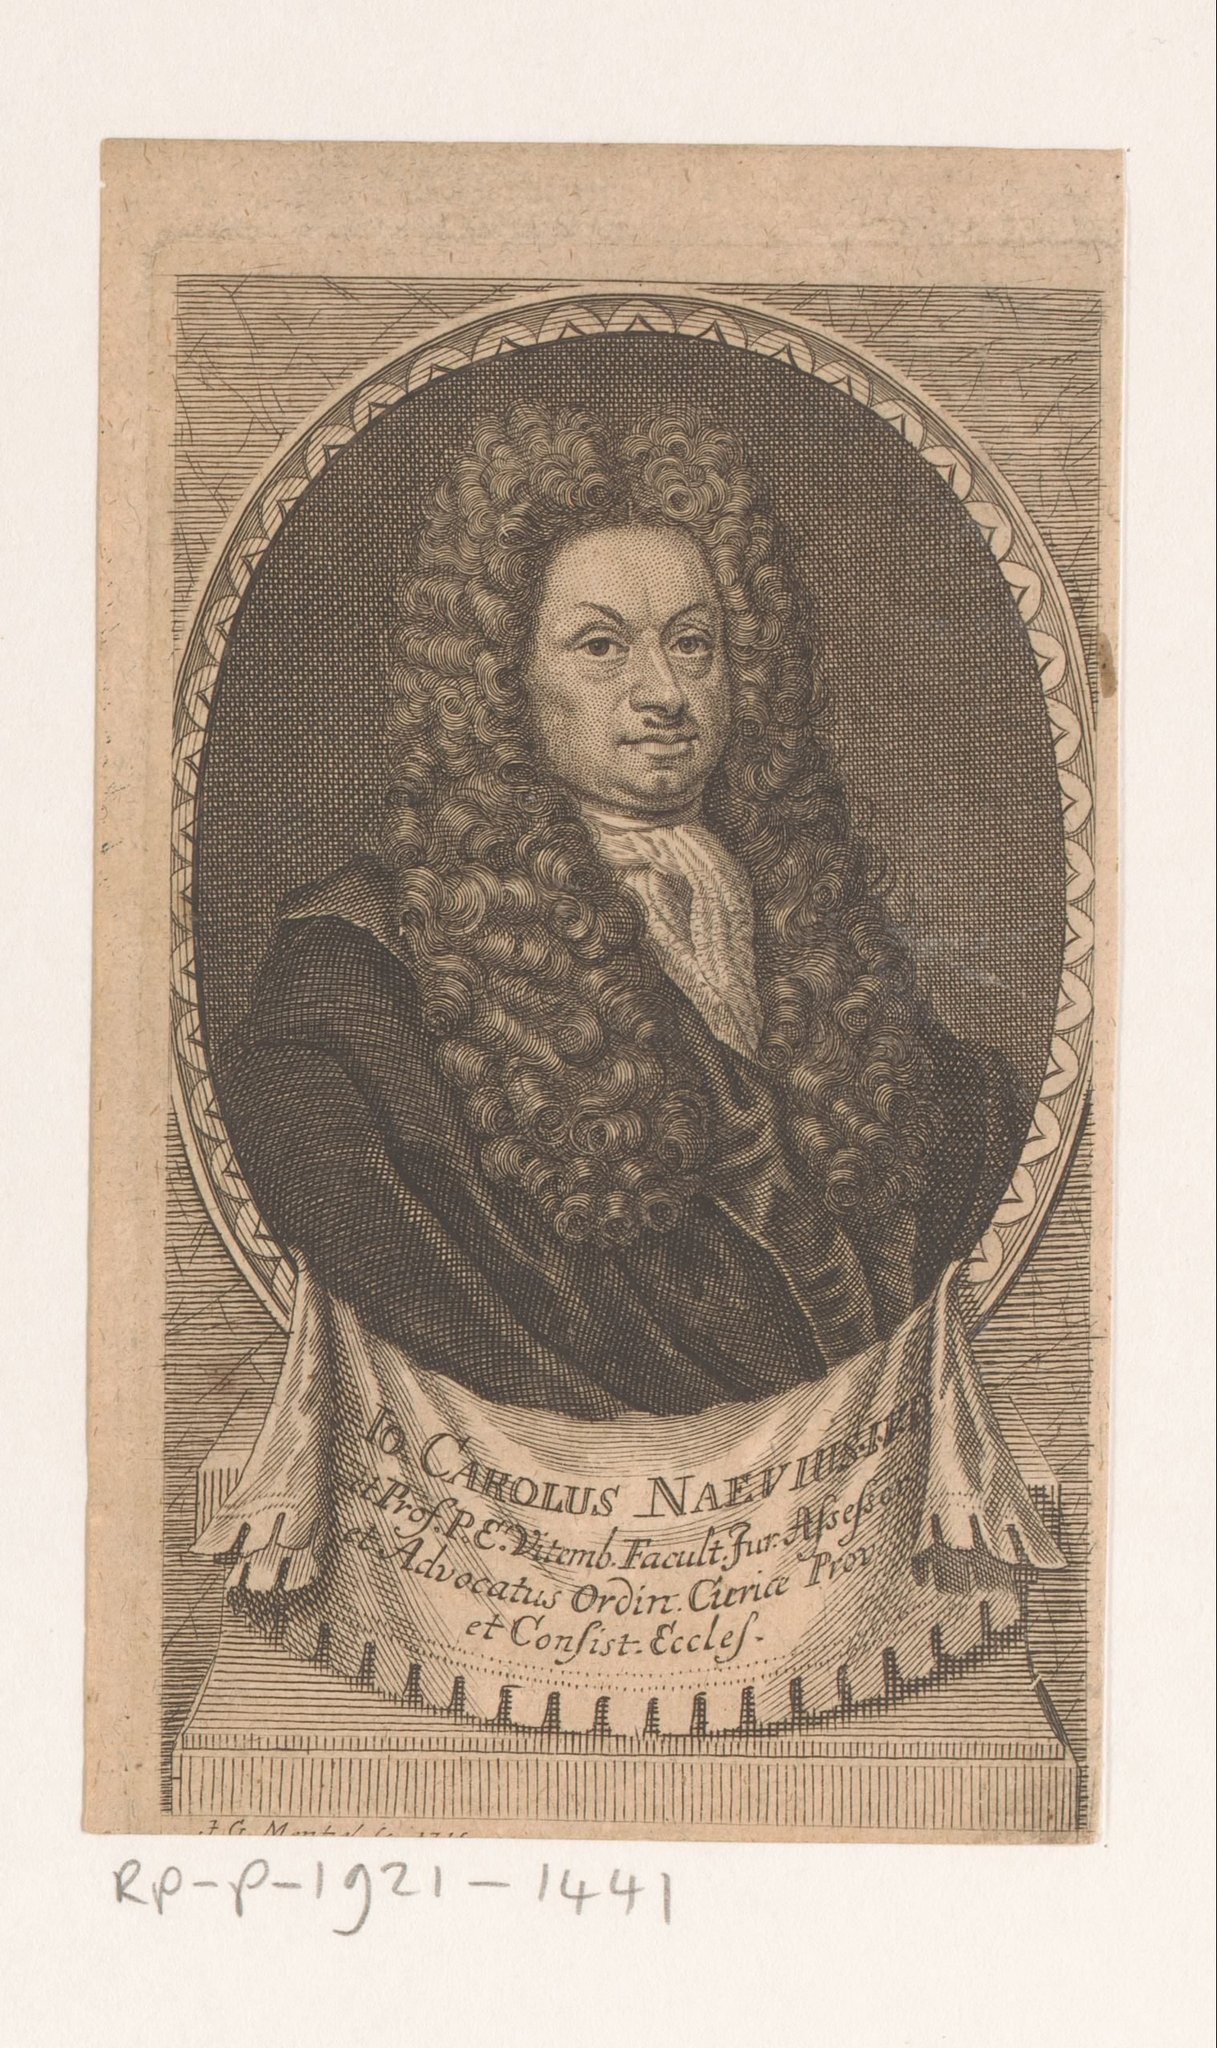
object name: print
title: Portret van Johann Carl Naeve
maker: johann georg mentzel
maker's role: print maker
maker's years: 1677-1743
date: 1716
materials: paper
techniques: engraving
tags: historical persons, wig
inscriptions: collector's mark: Lugt 2228